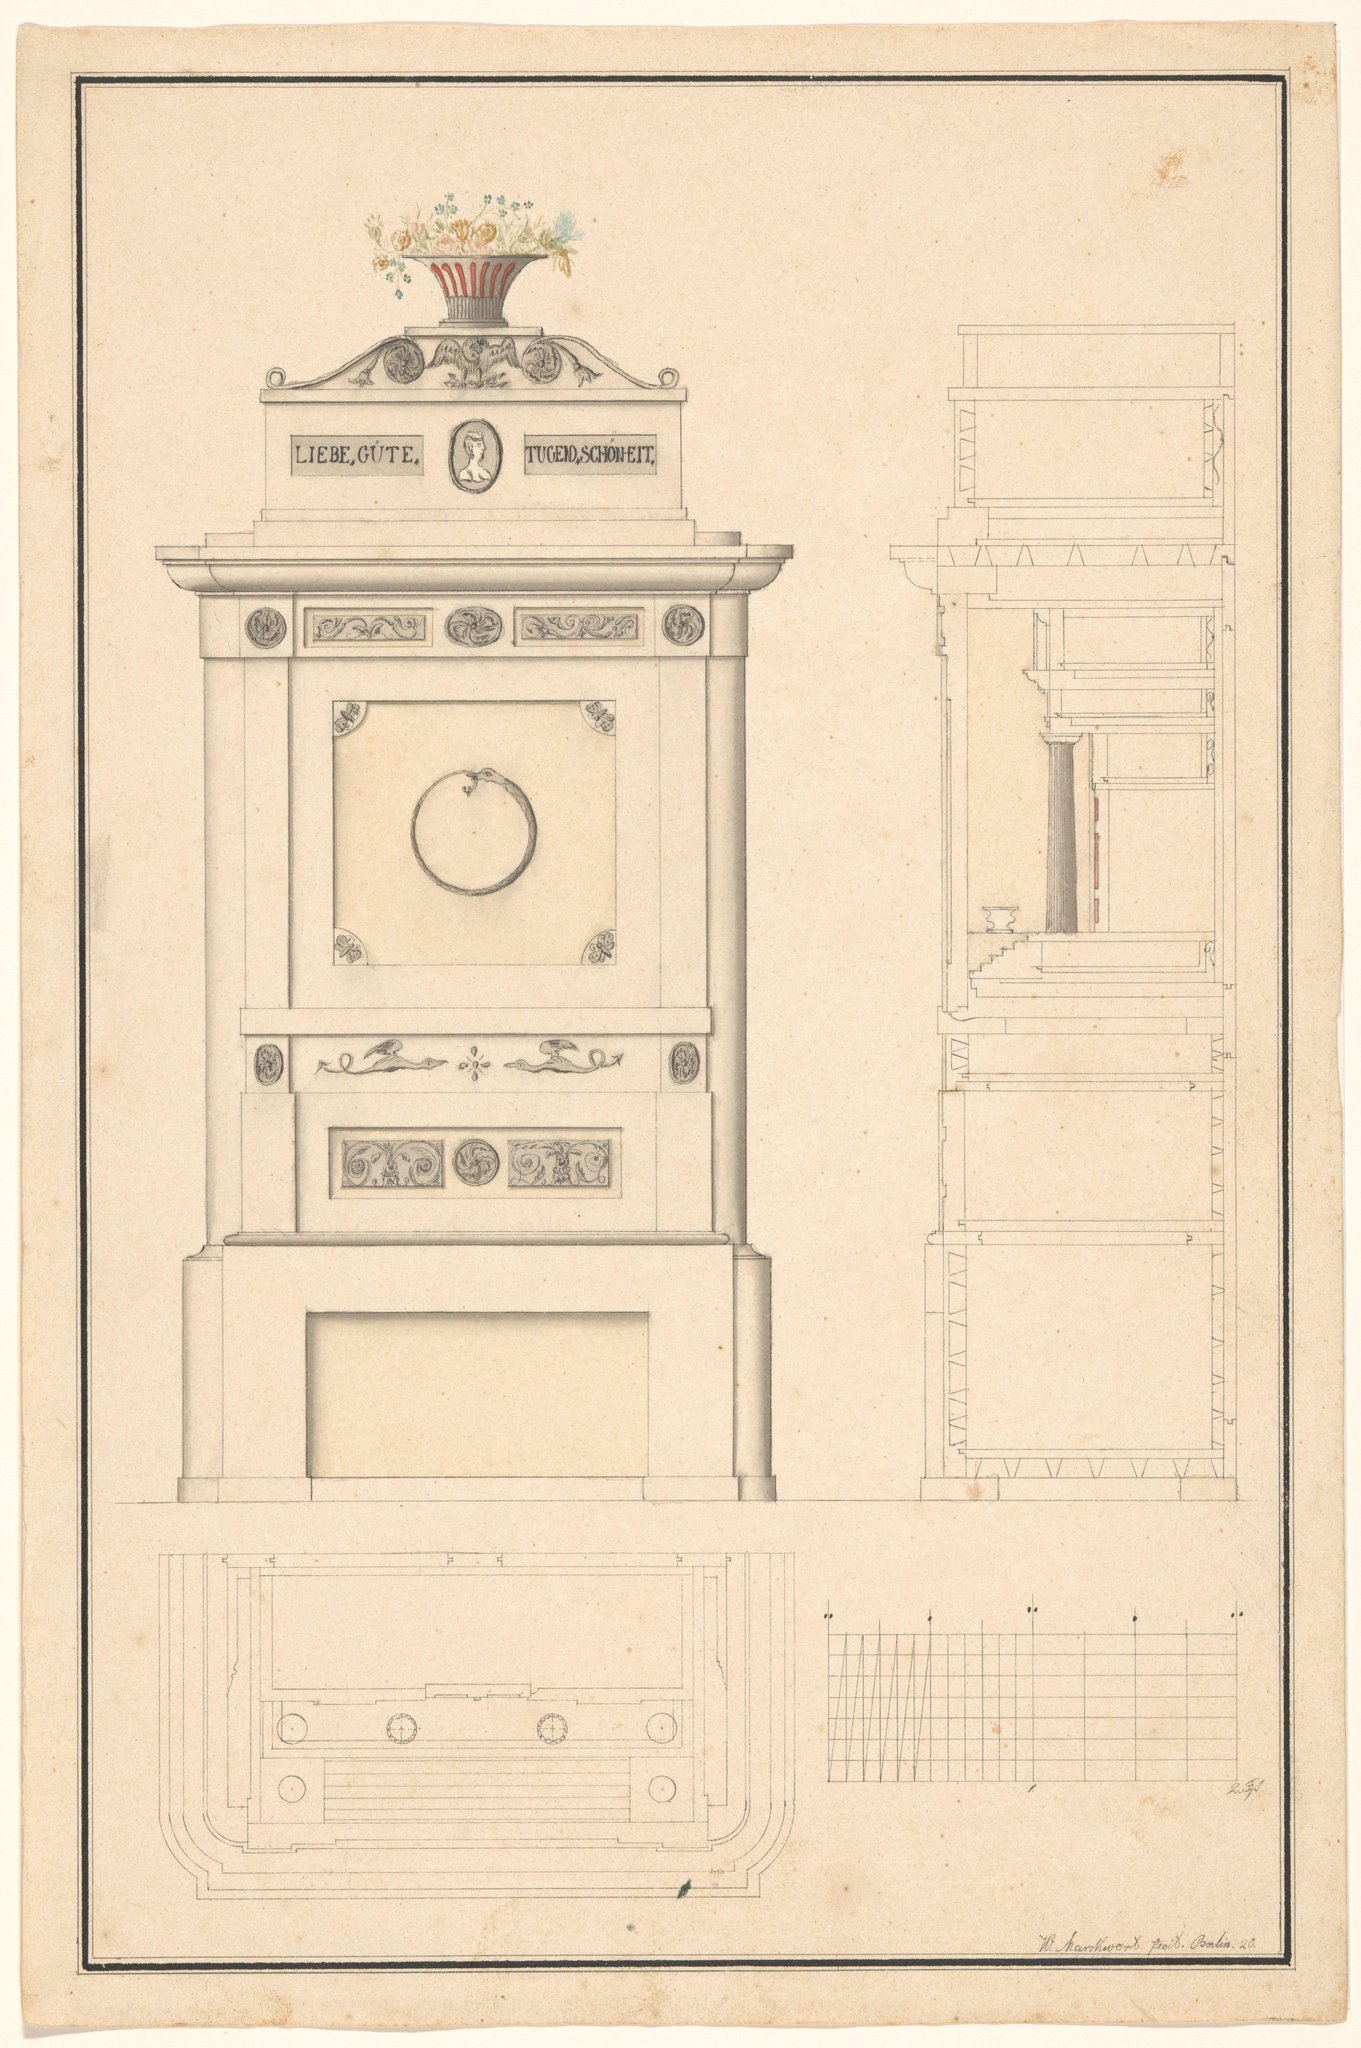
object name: drawing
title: Acht meubeltekeningen door Carl Wilhelm Marckwort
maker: carl wilhelm marckwort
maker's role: draughtsman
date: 1820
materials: ink, paper, watercolor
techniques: brush, pen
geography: berlin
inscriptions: signature and date: ‘W. Marckwort. fecit. Berlin. 20.’, watermark: ‘J WHATMAN / TURKEY MILL / 1821 [sic].’, inscription: ‘LIEBE, GÜTE, TUGEND, SCHÖNHEIT’, inscription: ‘1 / 2 Fuss’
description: Voor- en zijaanzicht, met daaronder een doorsnede en een maatverdeling.